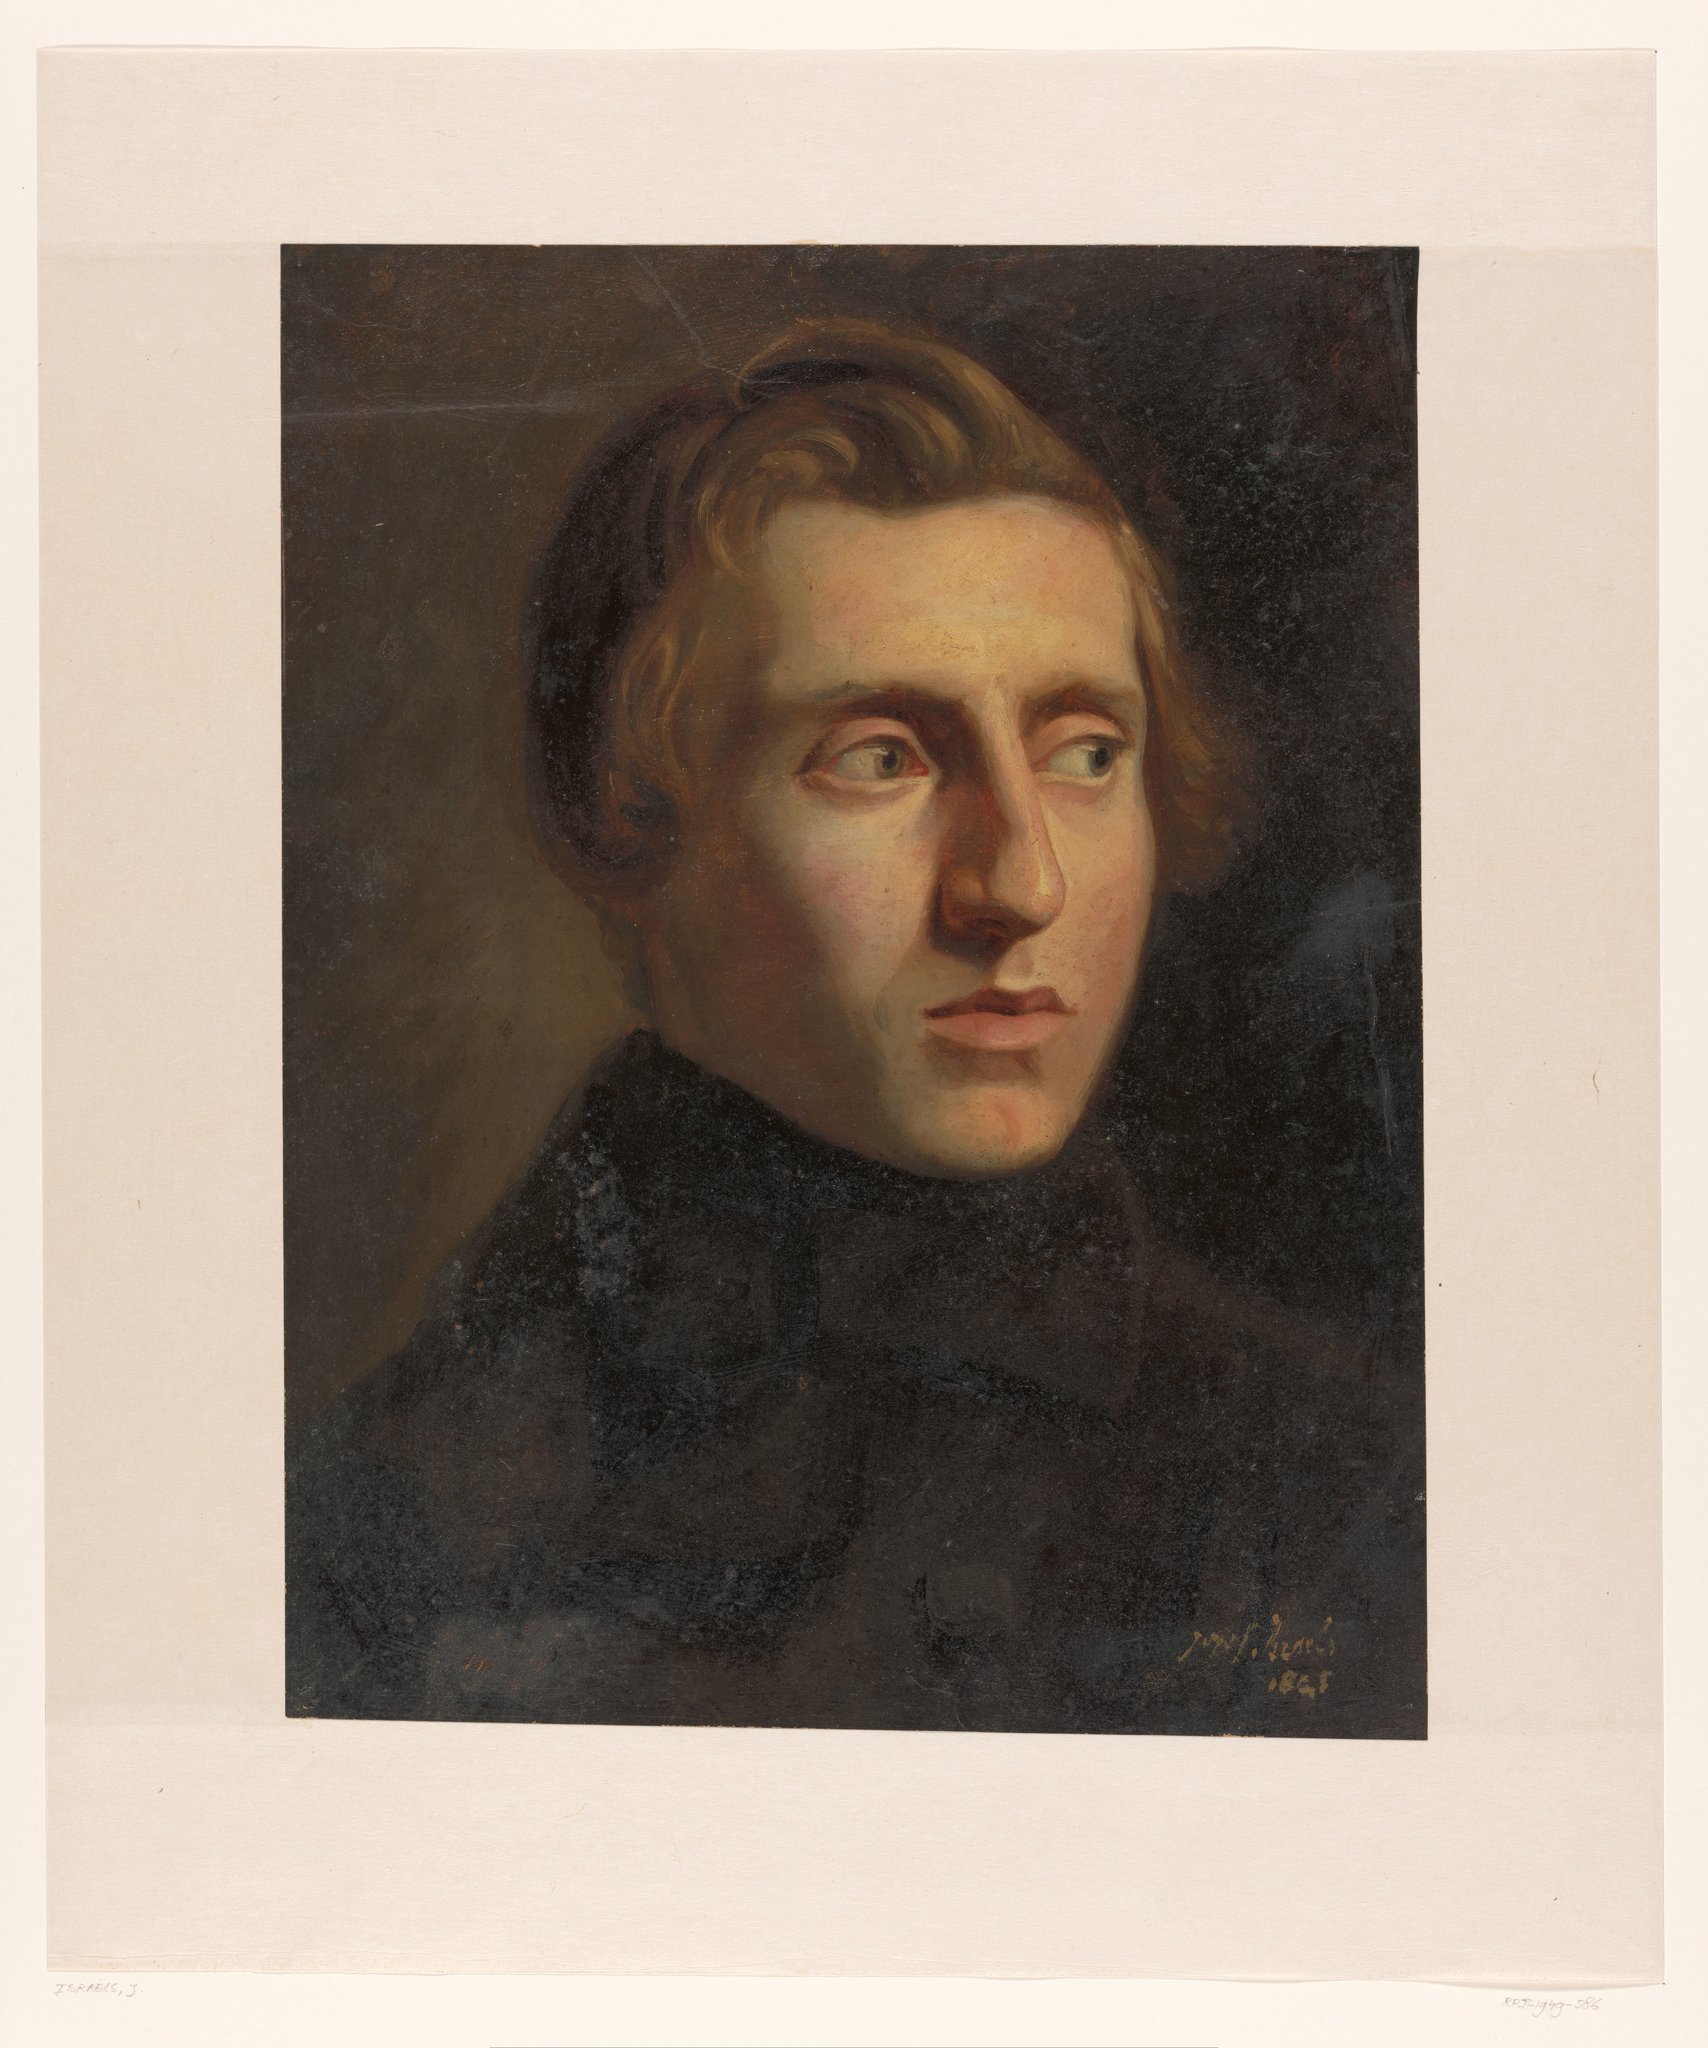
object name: painting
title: Portret van een jonge man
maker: jozef israëls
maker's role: draughtsman, painter, print maker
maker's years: 1824-1911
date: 1845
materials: linen, oil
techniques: brush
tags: anonymous historical person portrayed alone